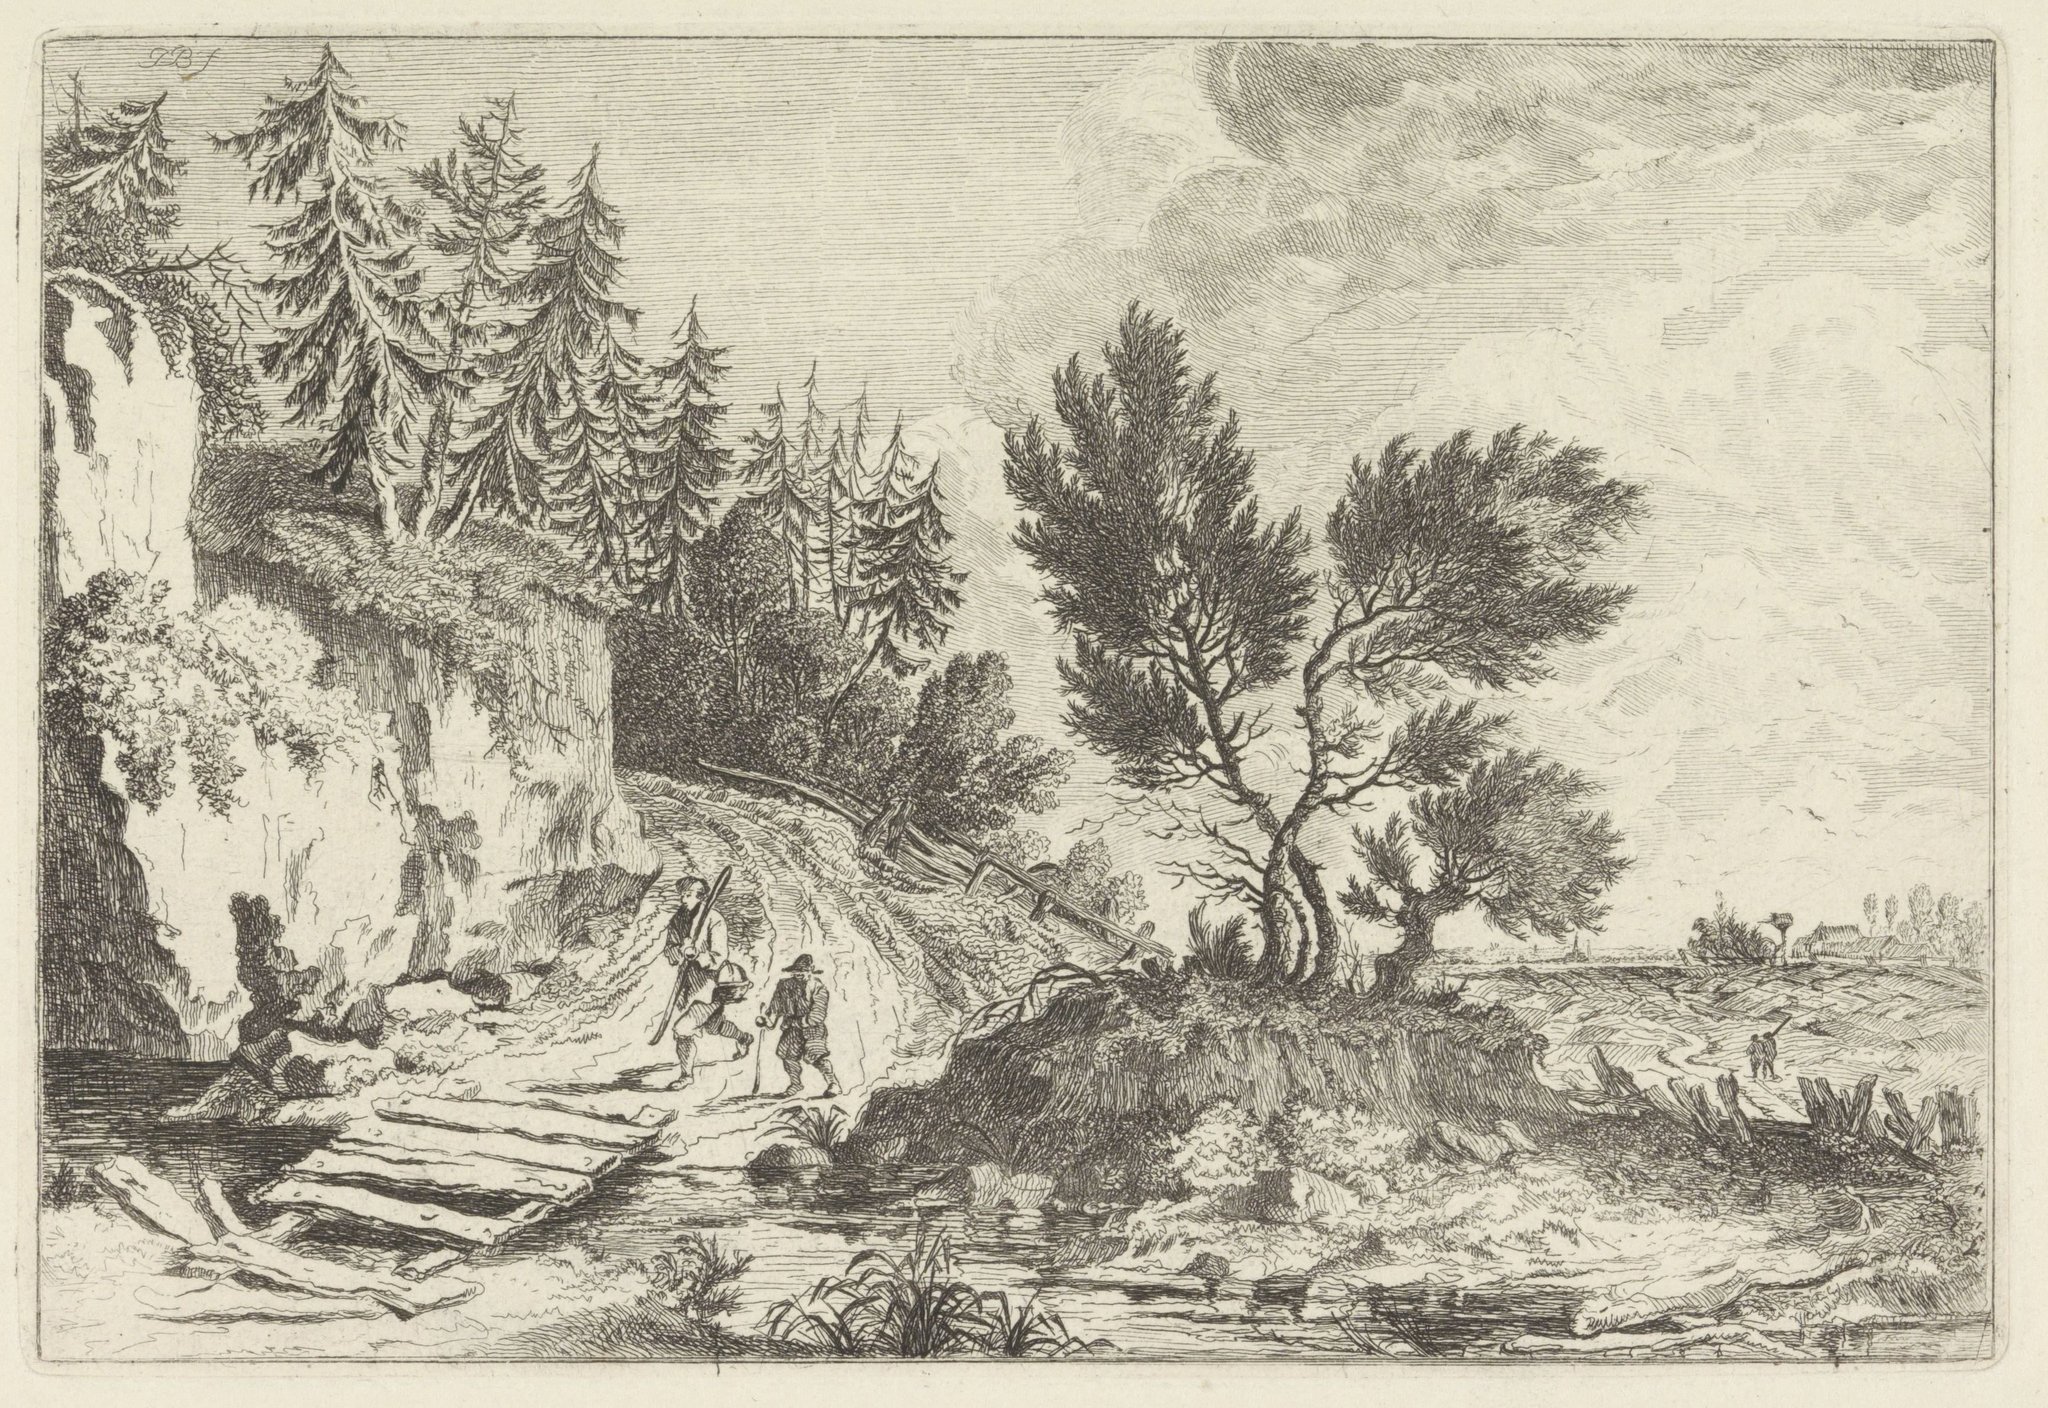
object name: print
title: Twee wandelaars bij een brug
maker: joannes bemme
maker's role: print maker, printer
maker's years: 1775-1841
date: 1795-1810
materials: paper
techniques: etching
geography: rotterdam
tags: mountains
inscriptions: collector's mark: Lugt 2228